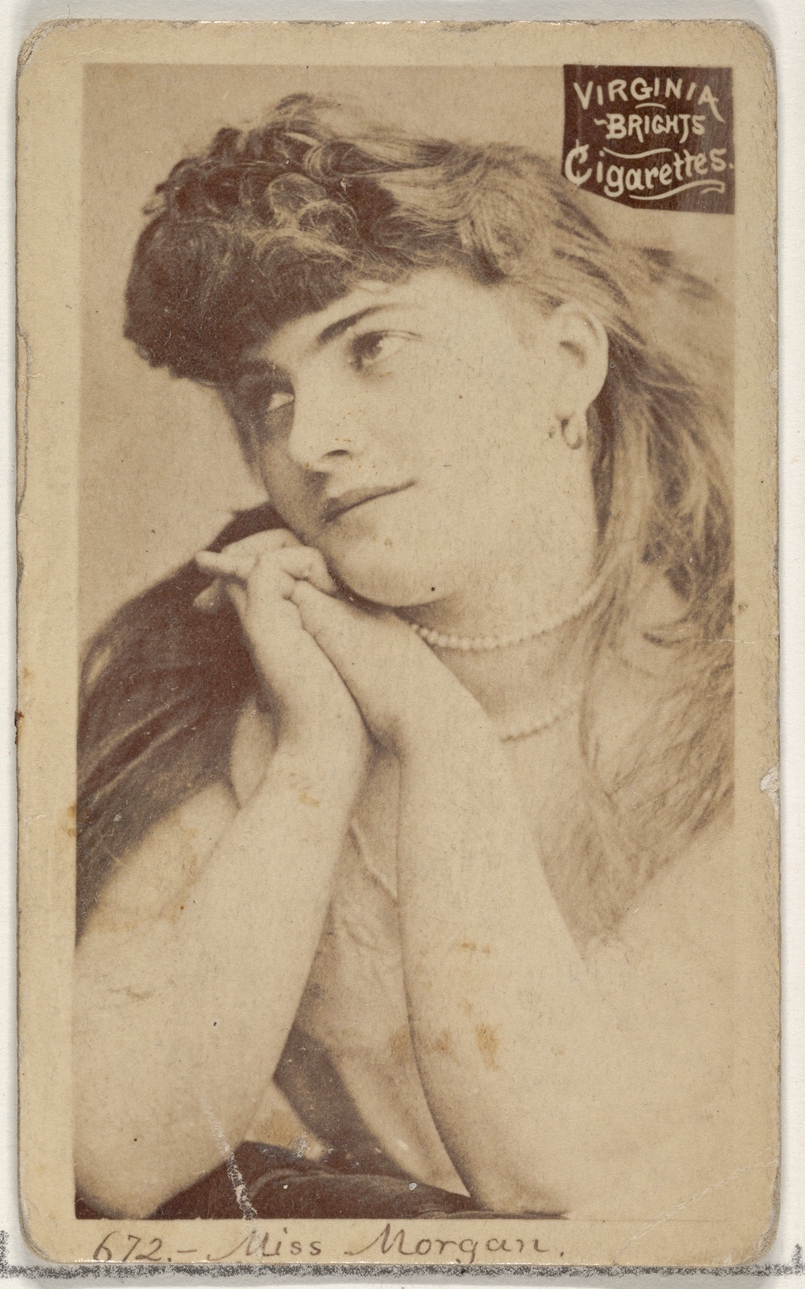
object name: photograph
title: Card 672, Miss Morgan, from the Actors and Actresses series (N45, Type 2) for Virginia Brights Cigarettes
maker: allen & ginter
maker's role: publisher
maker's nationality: american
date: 1888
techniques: albumen silver print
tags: portraits,women,actresses